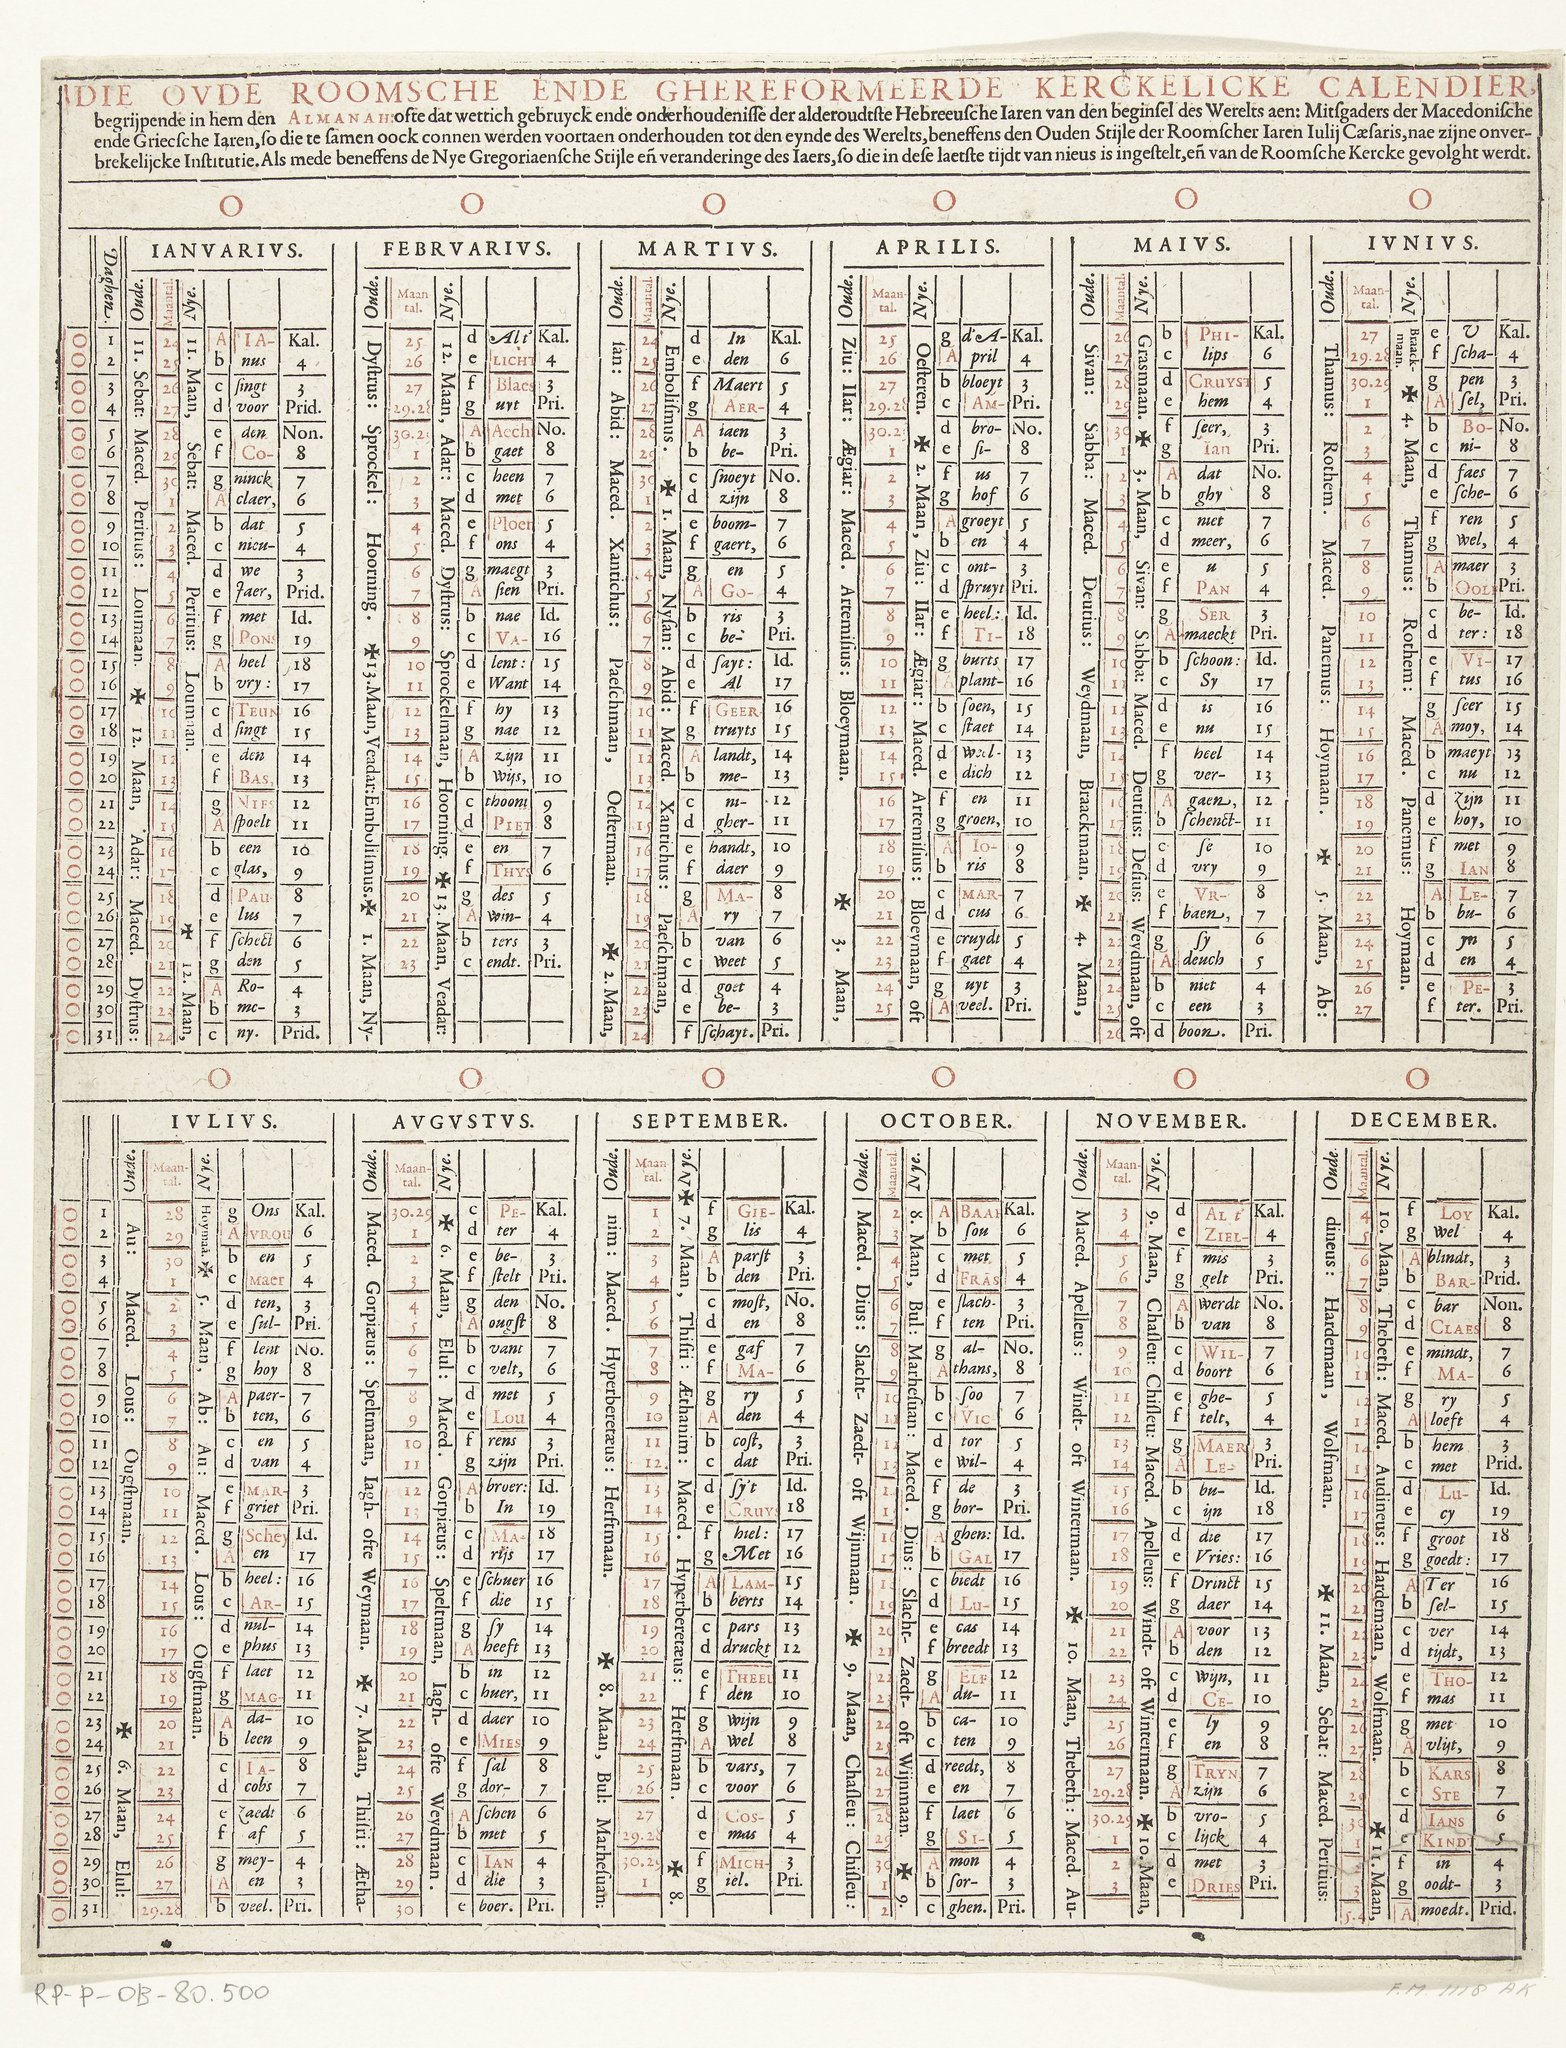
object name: print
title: Die oude roomsche ende ghereformeerde kerckelicke Calendier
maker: Anonymous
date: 1590-1649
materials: paper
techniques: letterpress printing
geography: low countries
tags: calendar, almanac, low countries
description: Oude plakalmanak of kalender, ca. 1600. Jaarkalender uit een almanak met indeling in kolommen volgens oude katholieke en gereformeerde gebruiken.